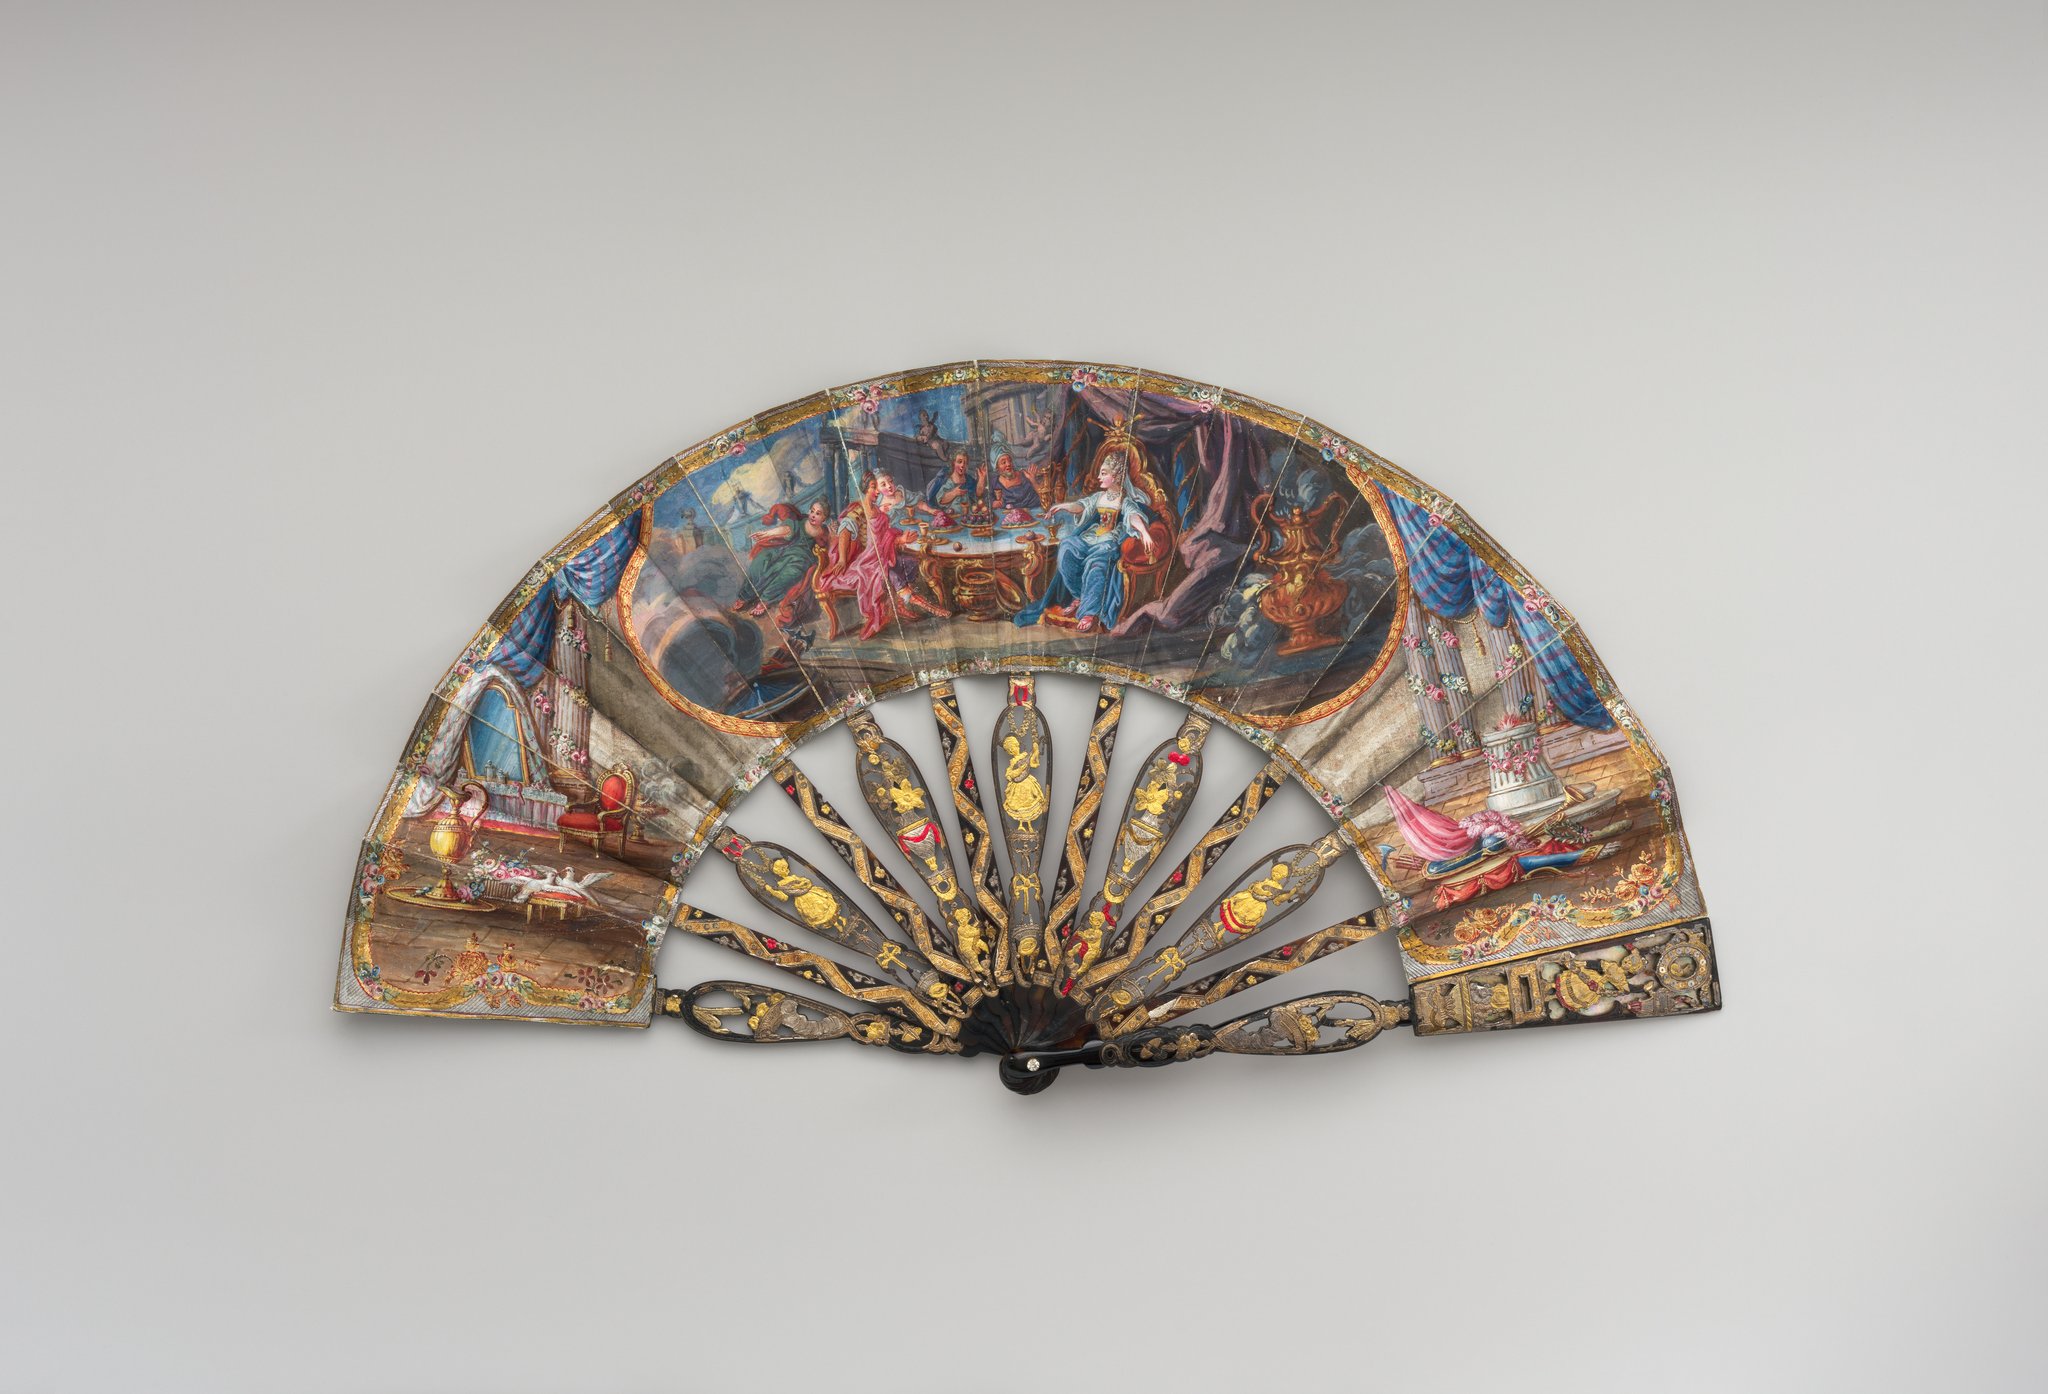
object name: fan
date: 1751-1775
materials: gilt, glass, gold, paint, parchment, shell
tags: women,banquets